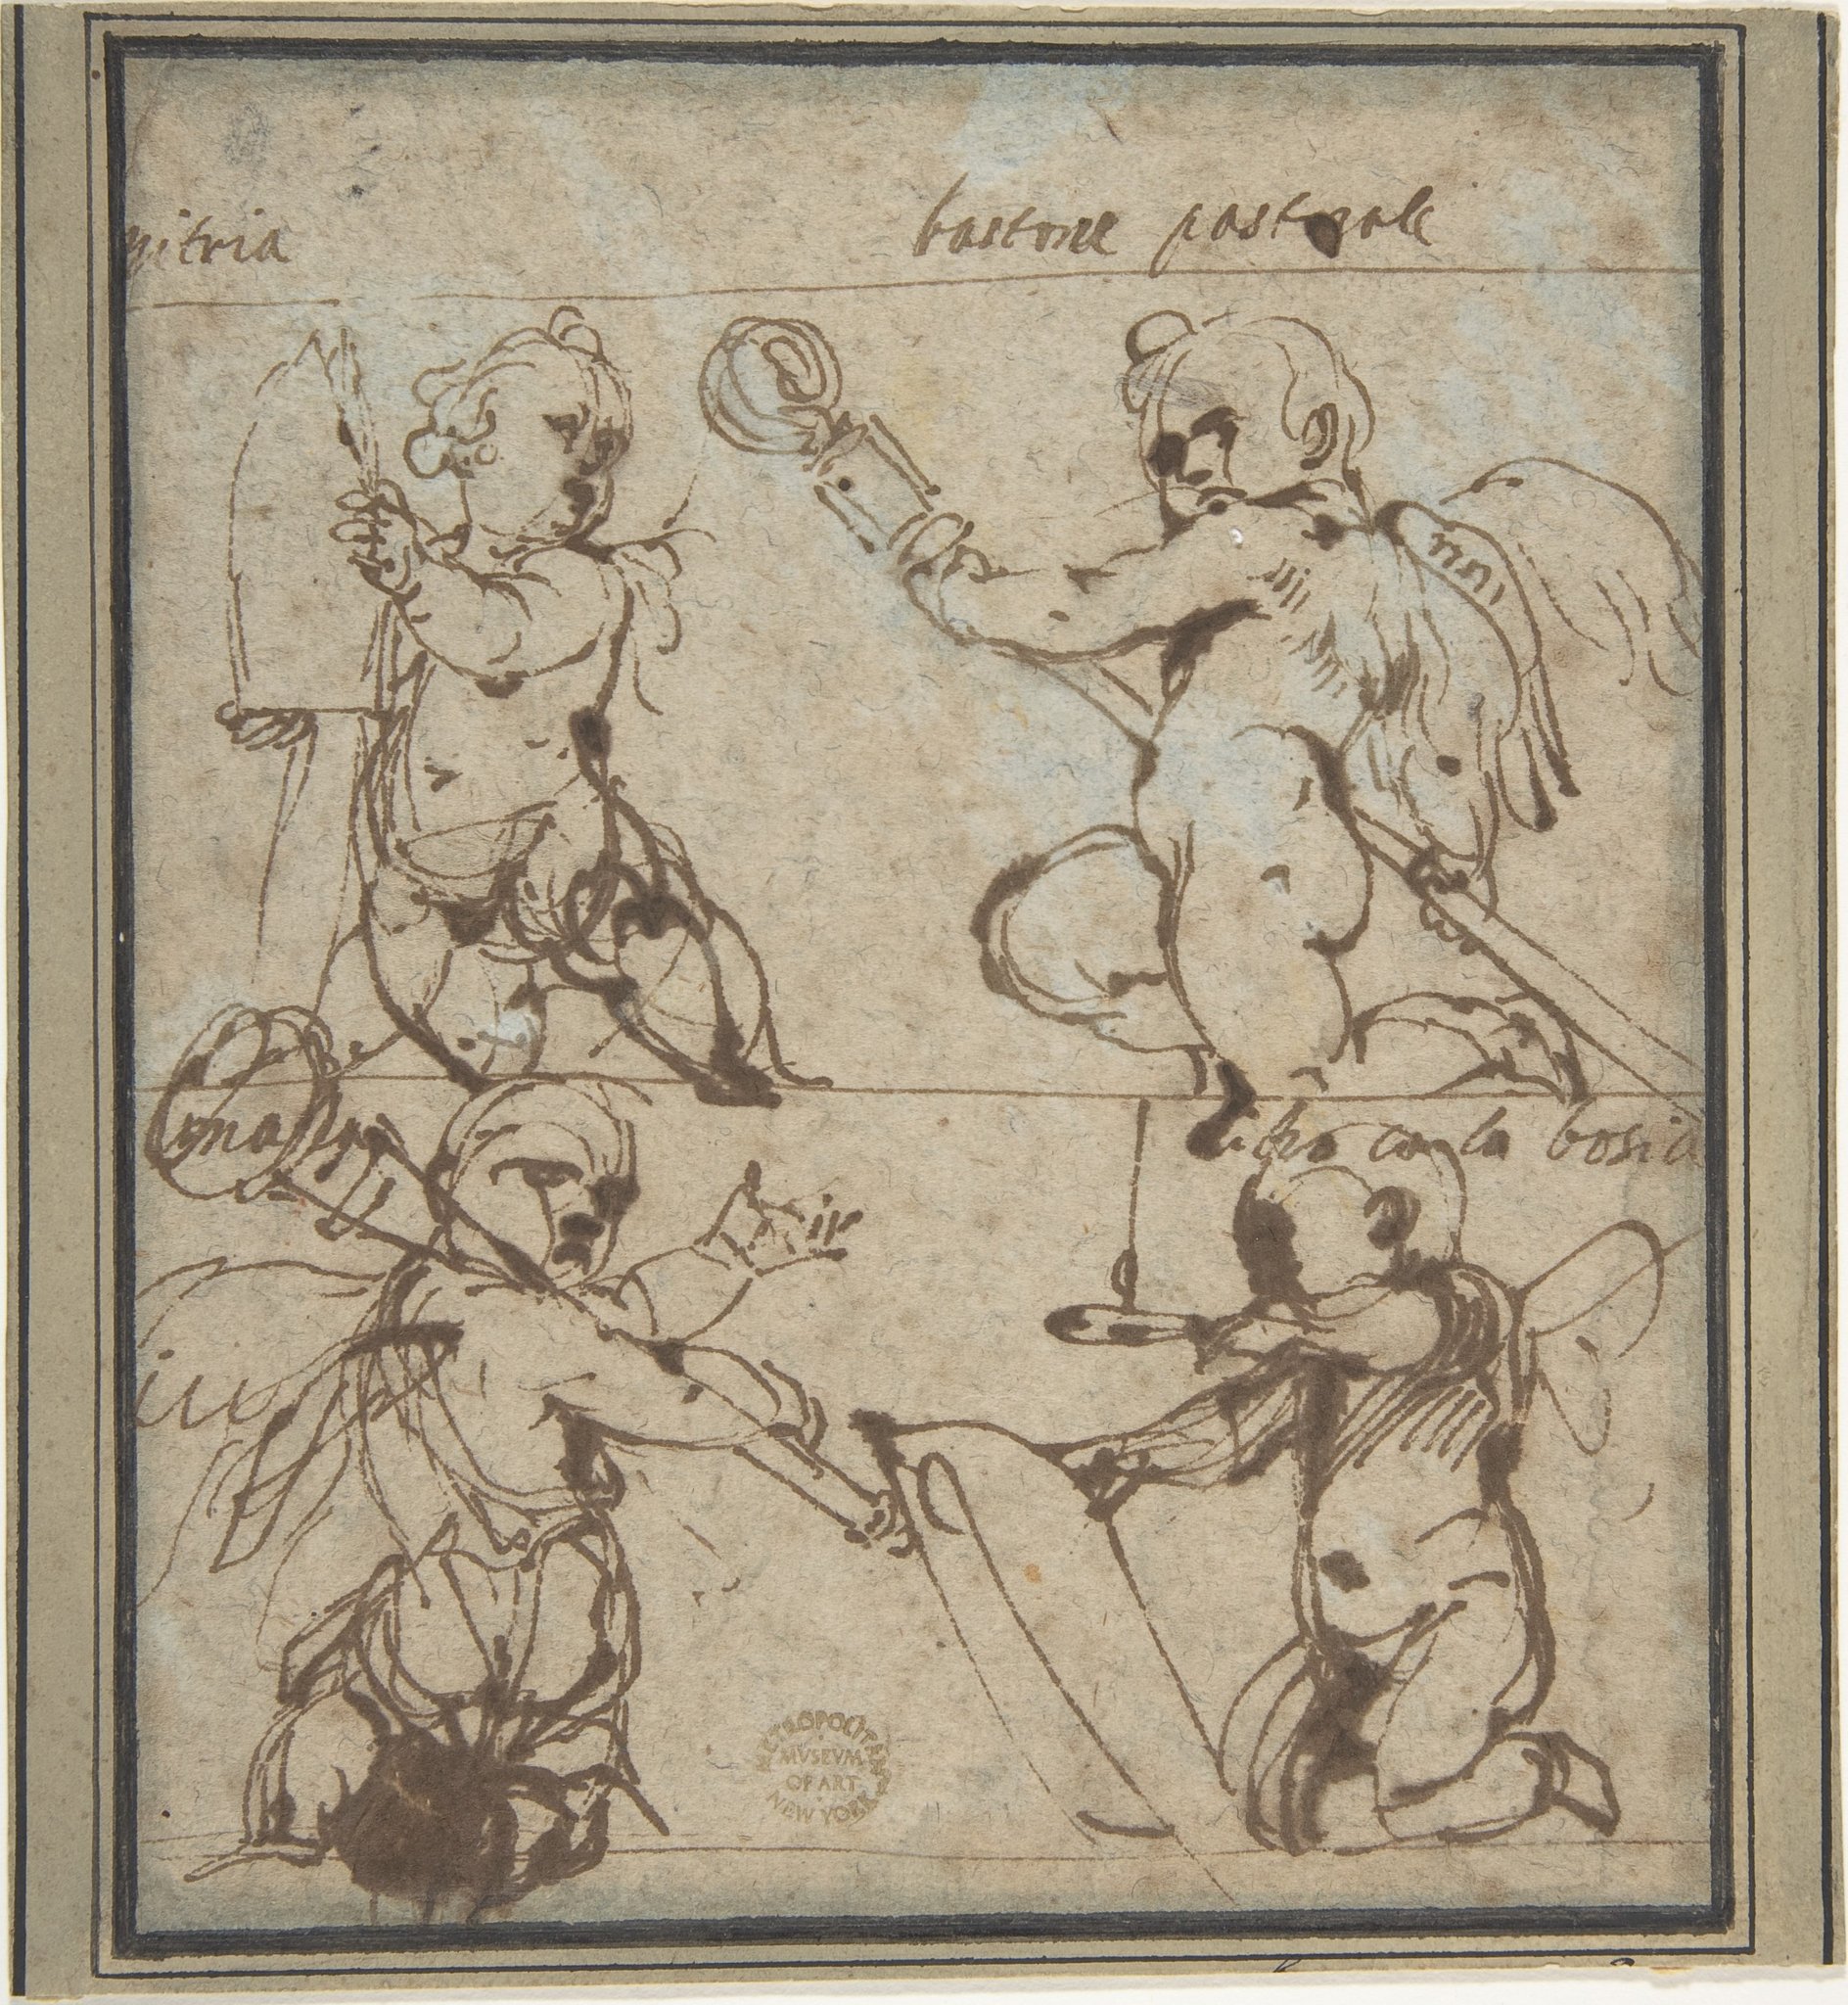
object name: drawing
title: Putti with a Mitre, Crosier Mace, Book, and Candle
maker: daniele crespi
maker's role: artist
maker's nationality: italian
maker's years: 1597-1630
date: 1597-1630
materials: ink, paper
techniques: pen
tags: books,weapons,croziers,candles